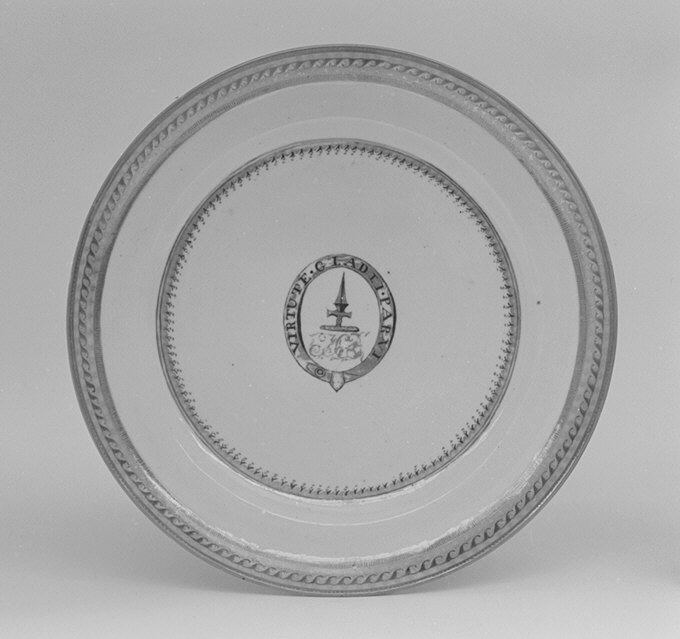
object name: plate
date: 1800-1810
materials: hard paste porcelain